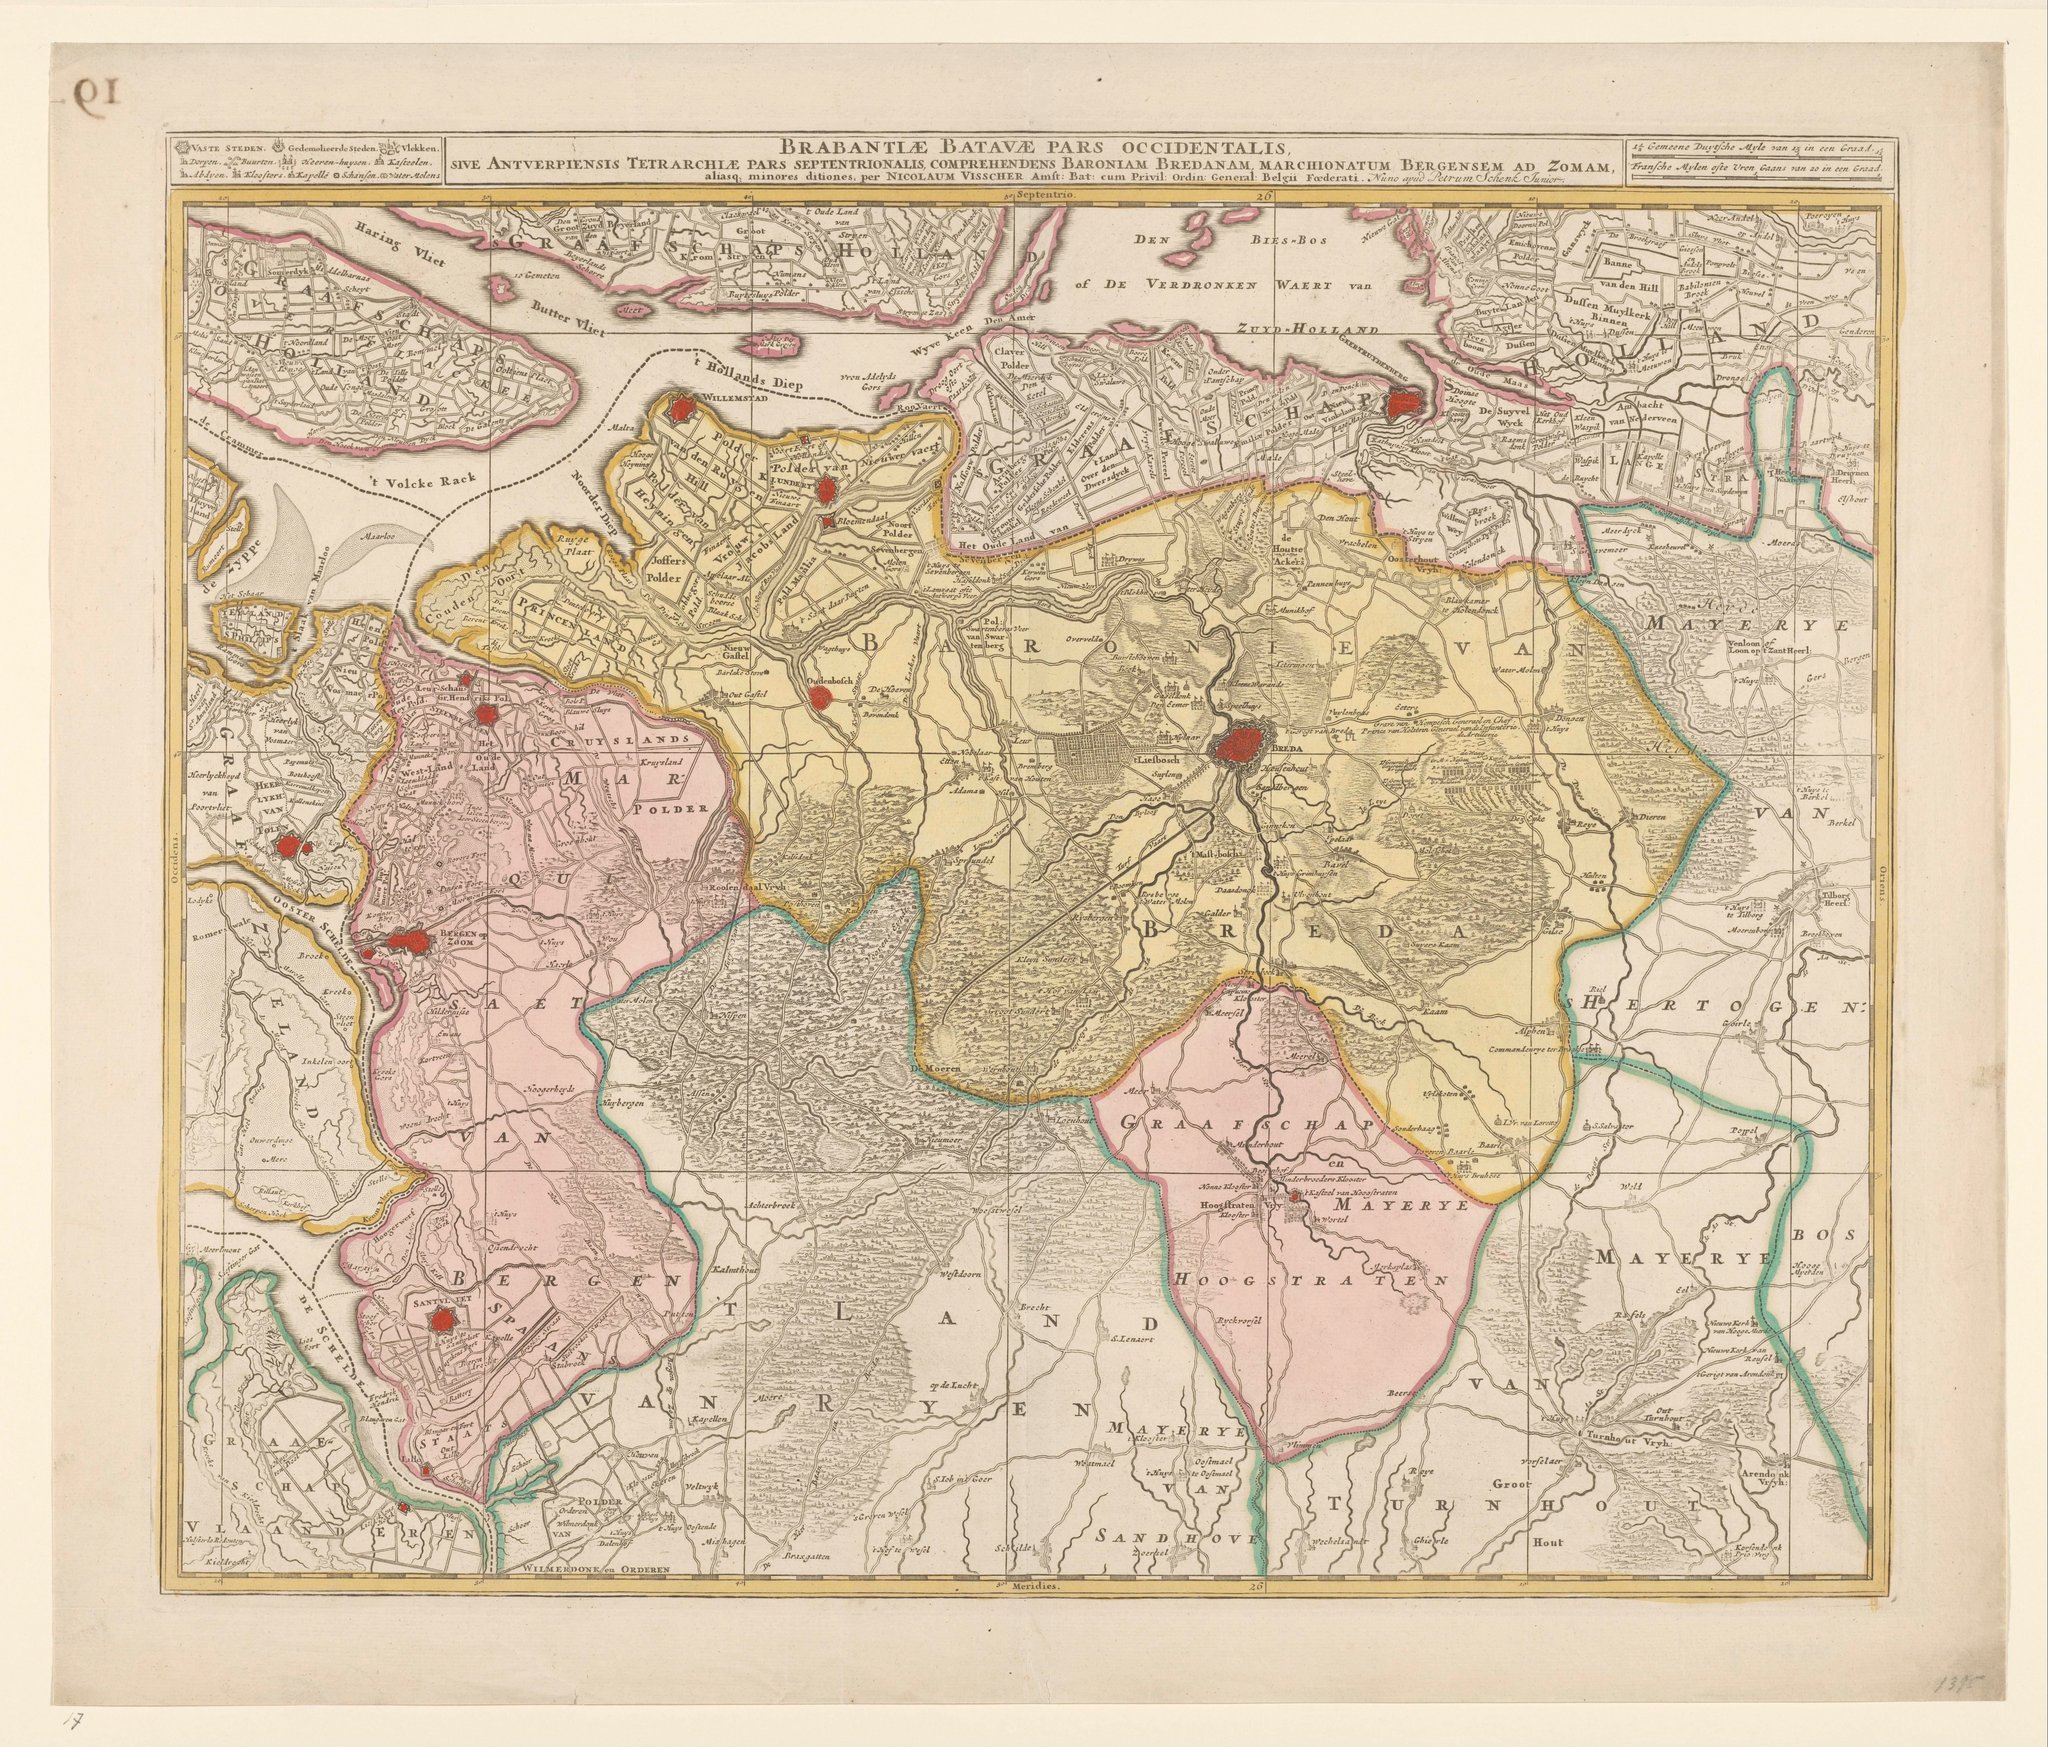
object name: map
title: Brabantiae Batavae pars occidentalis, sive Antverpiensis tetrarchiae pars septentrionalis : comprehendens Baroniam Bredanam, Marchionatum Bergensem ad Zomam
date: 1680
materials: paper, watercolor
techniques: engraving, hand coloring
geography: amsterdam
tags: maps of separate countries or regions, brabant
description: Kaart van de baronie van Breda en directe omgeving. Linksboven legende van steden en dorpen. Rechtsboven de schaal in Duitse en Franse mijlen.